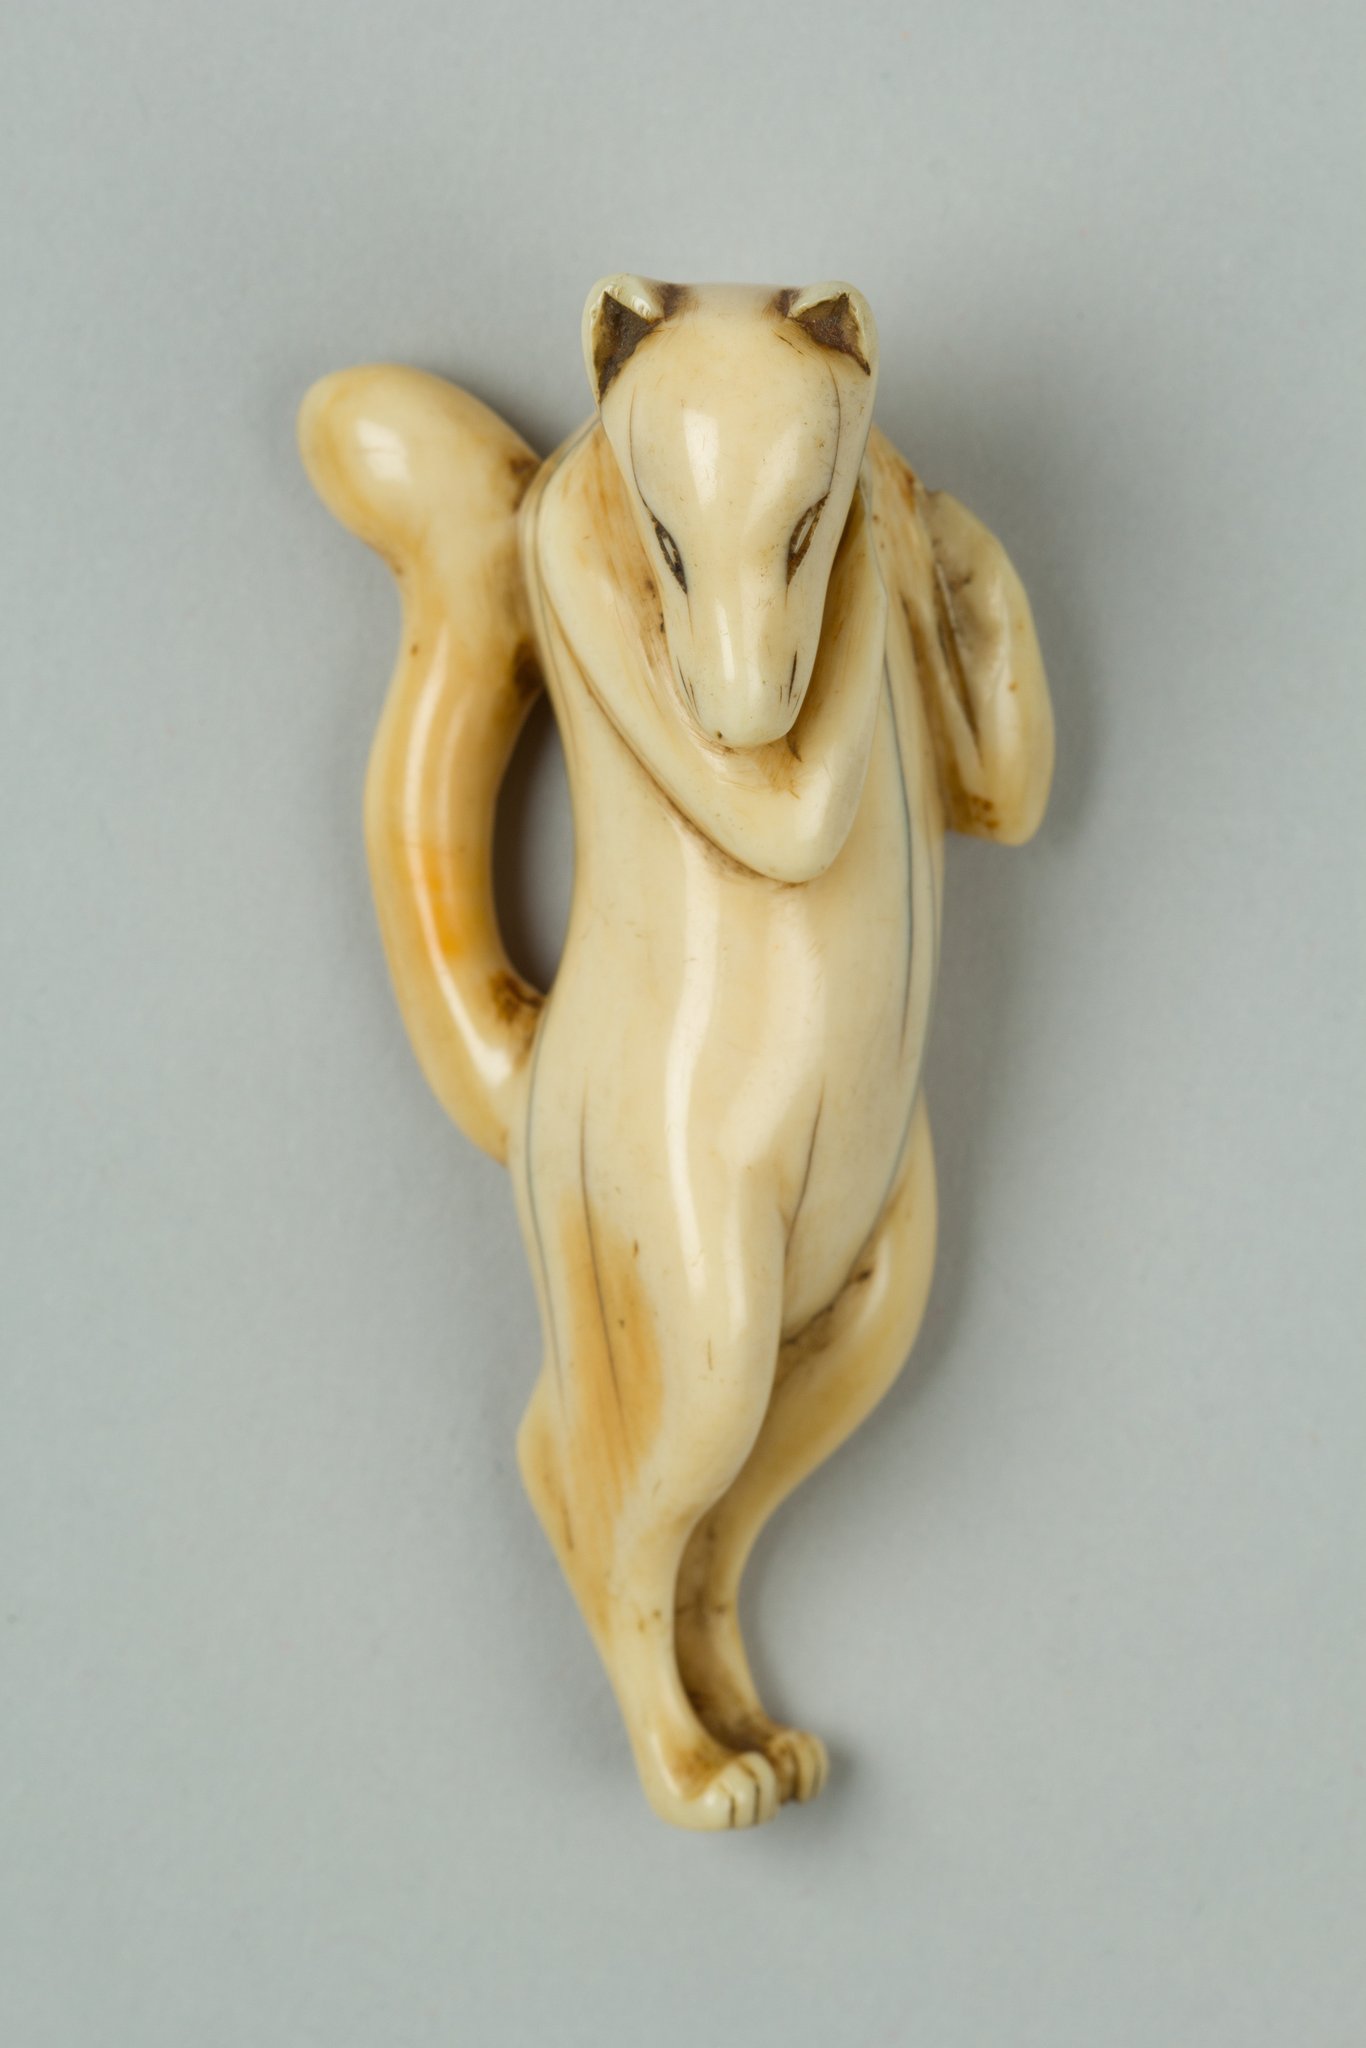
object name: netsuke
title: Netsuke of Fox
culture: japanese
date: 1801-1900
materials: ivory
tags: foxes